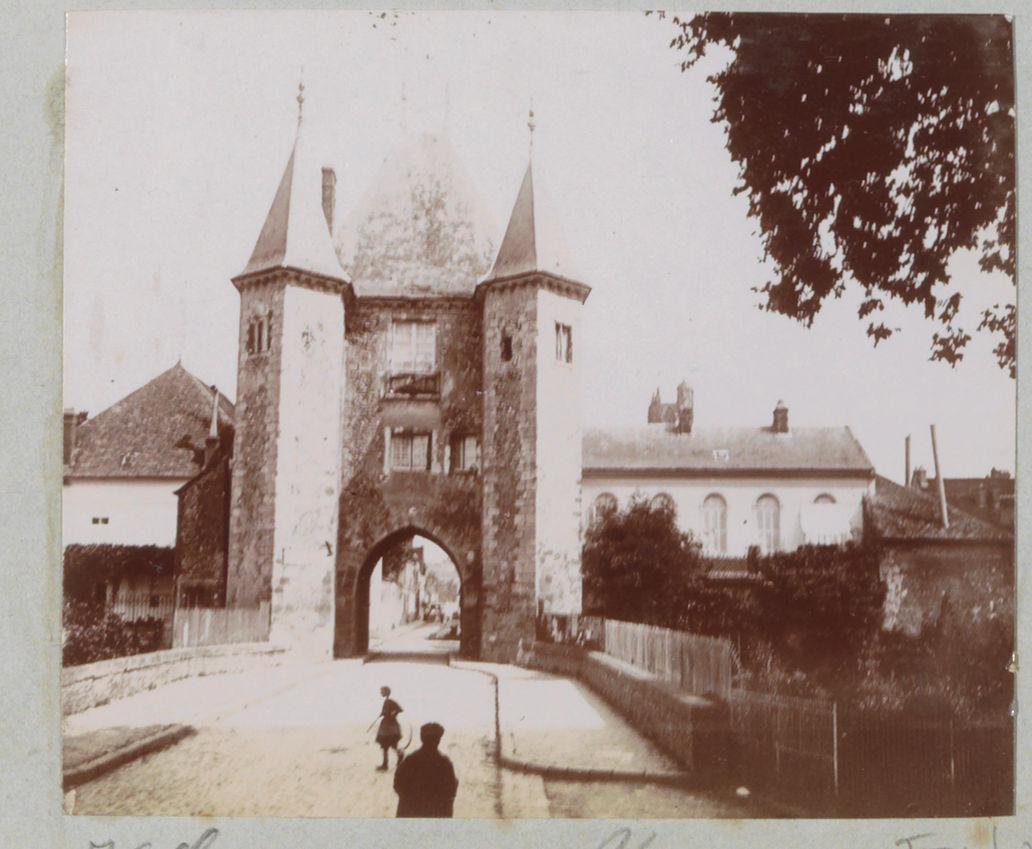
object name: photograph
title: Gezicht op een stadspoort in Villeneuve-sur-Yonne, met op de voorgrond (mogelijk) de schaduw van de fotograaf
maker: delizy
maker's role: manufacturer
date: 1904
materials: paper, photographic support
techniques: gelatin silver print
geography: villeneuve-sur-yonne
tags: man and his shadow, gate ~ fortified city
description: Onderdeel van Fotoalbum van een Franse amateurfotograaf met opnames van uitstapjes in Frankrijk, Spanje, België, Luxemburg en Nederland, de eerste automobielen en autoraces.